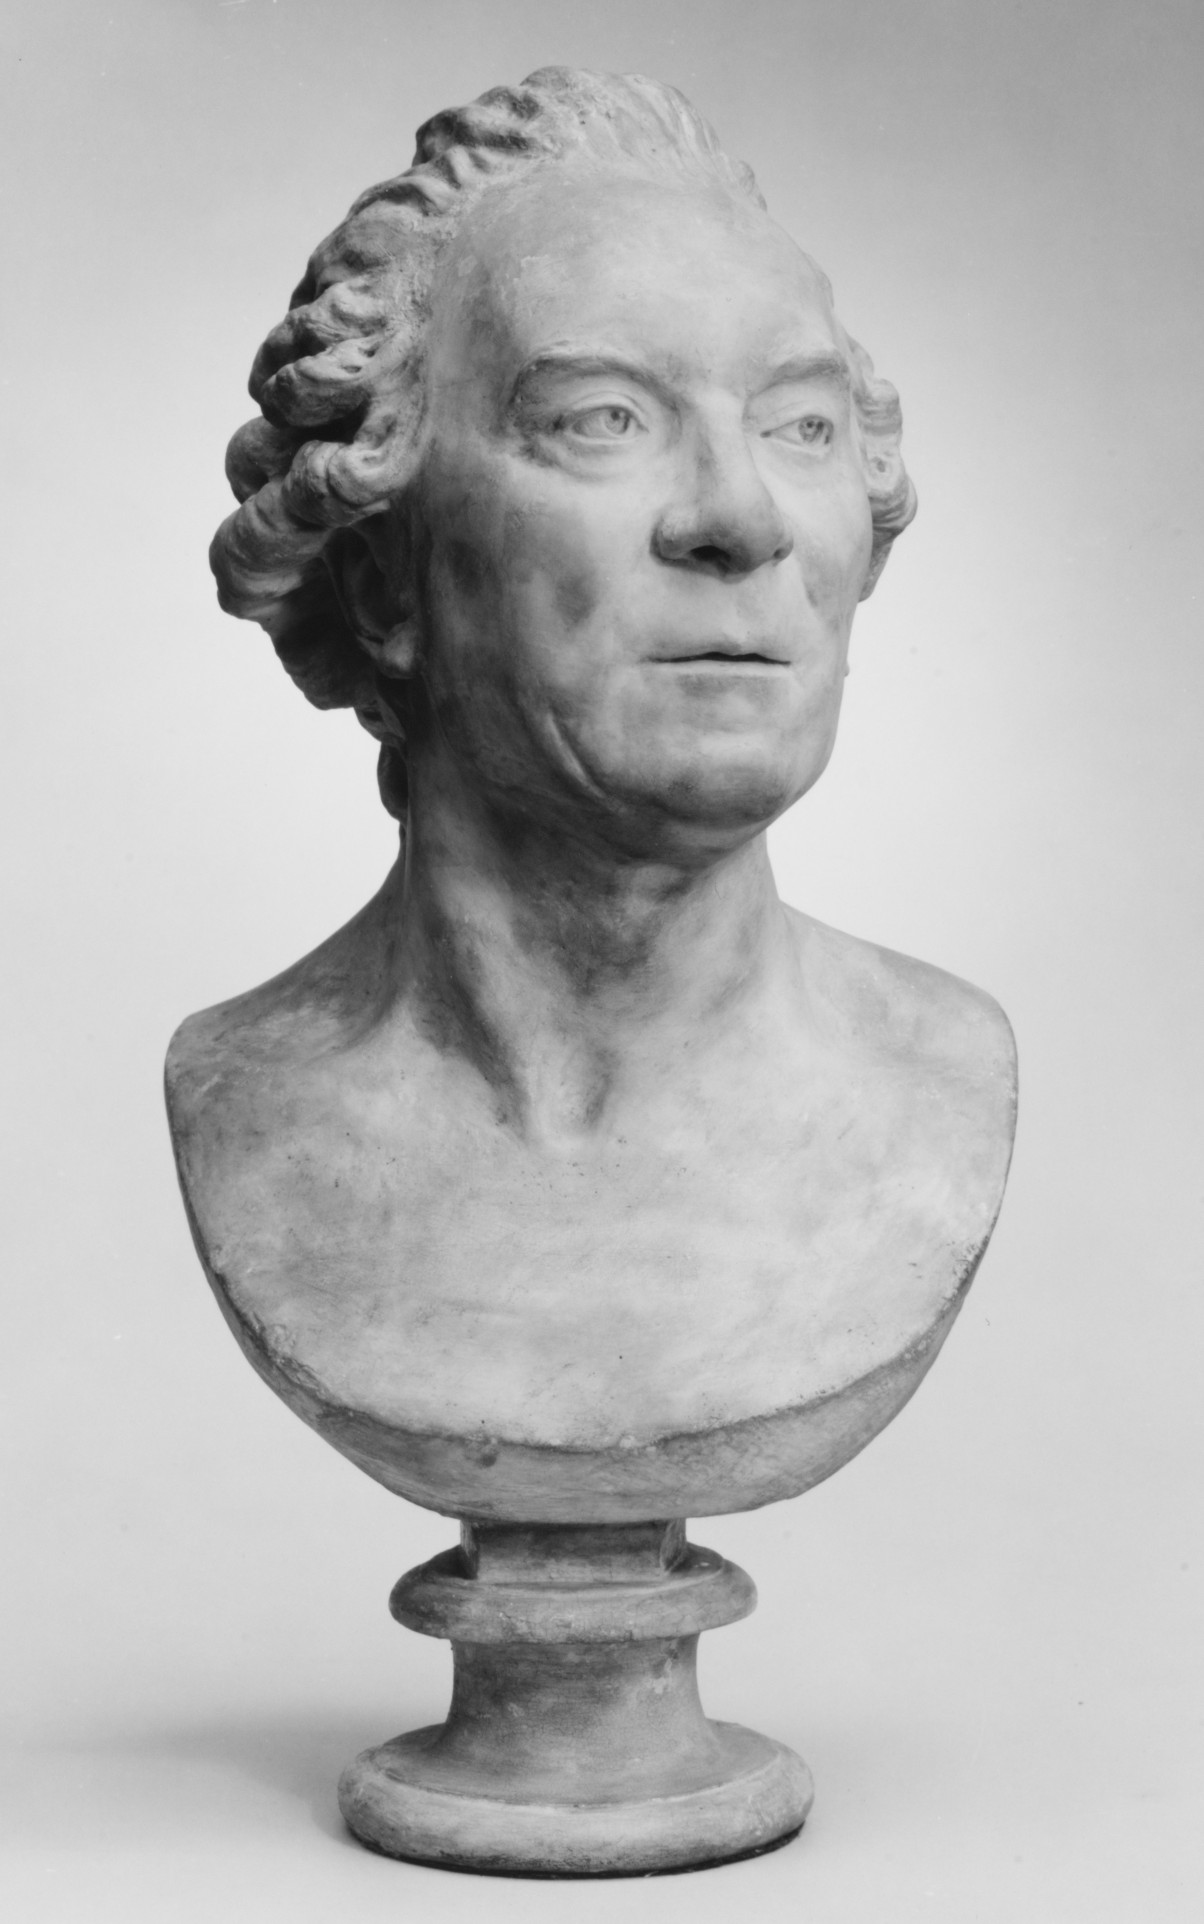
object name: bust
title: Georges-Louis-Leclerc, comte de Buffon (1707–1788)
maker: jean antoine houdon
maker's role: artist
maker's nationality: french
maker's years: 1741-1828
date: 1782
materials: plaster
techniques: tinting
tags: men,portraits